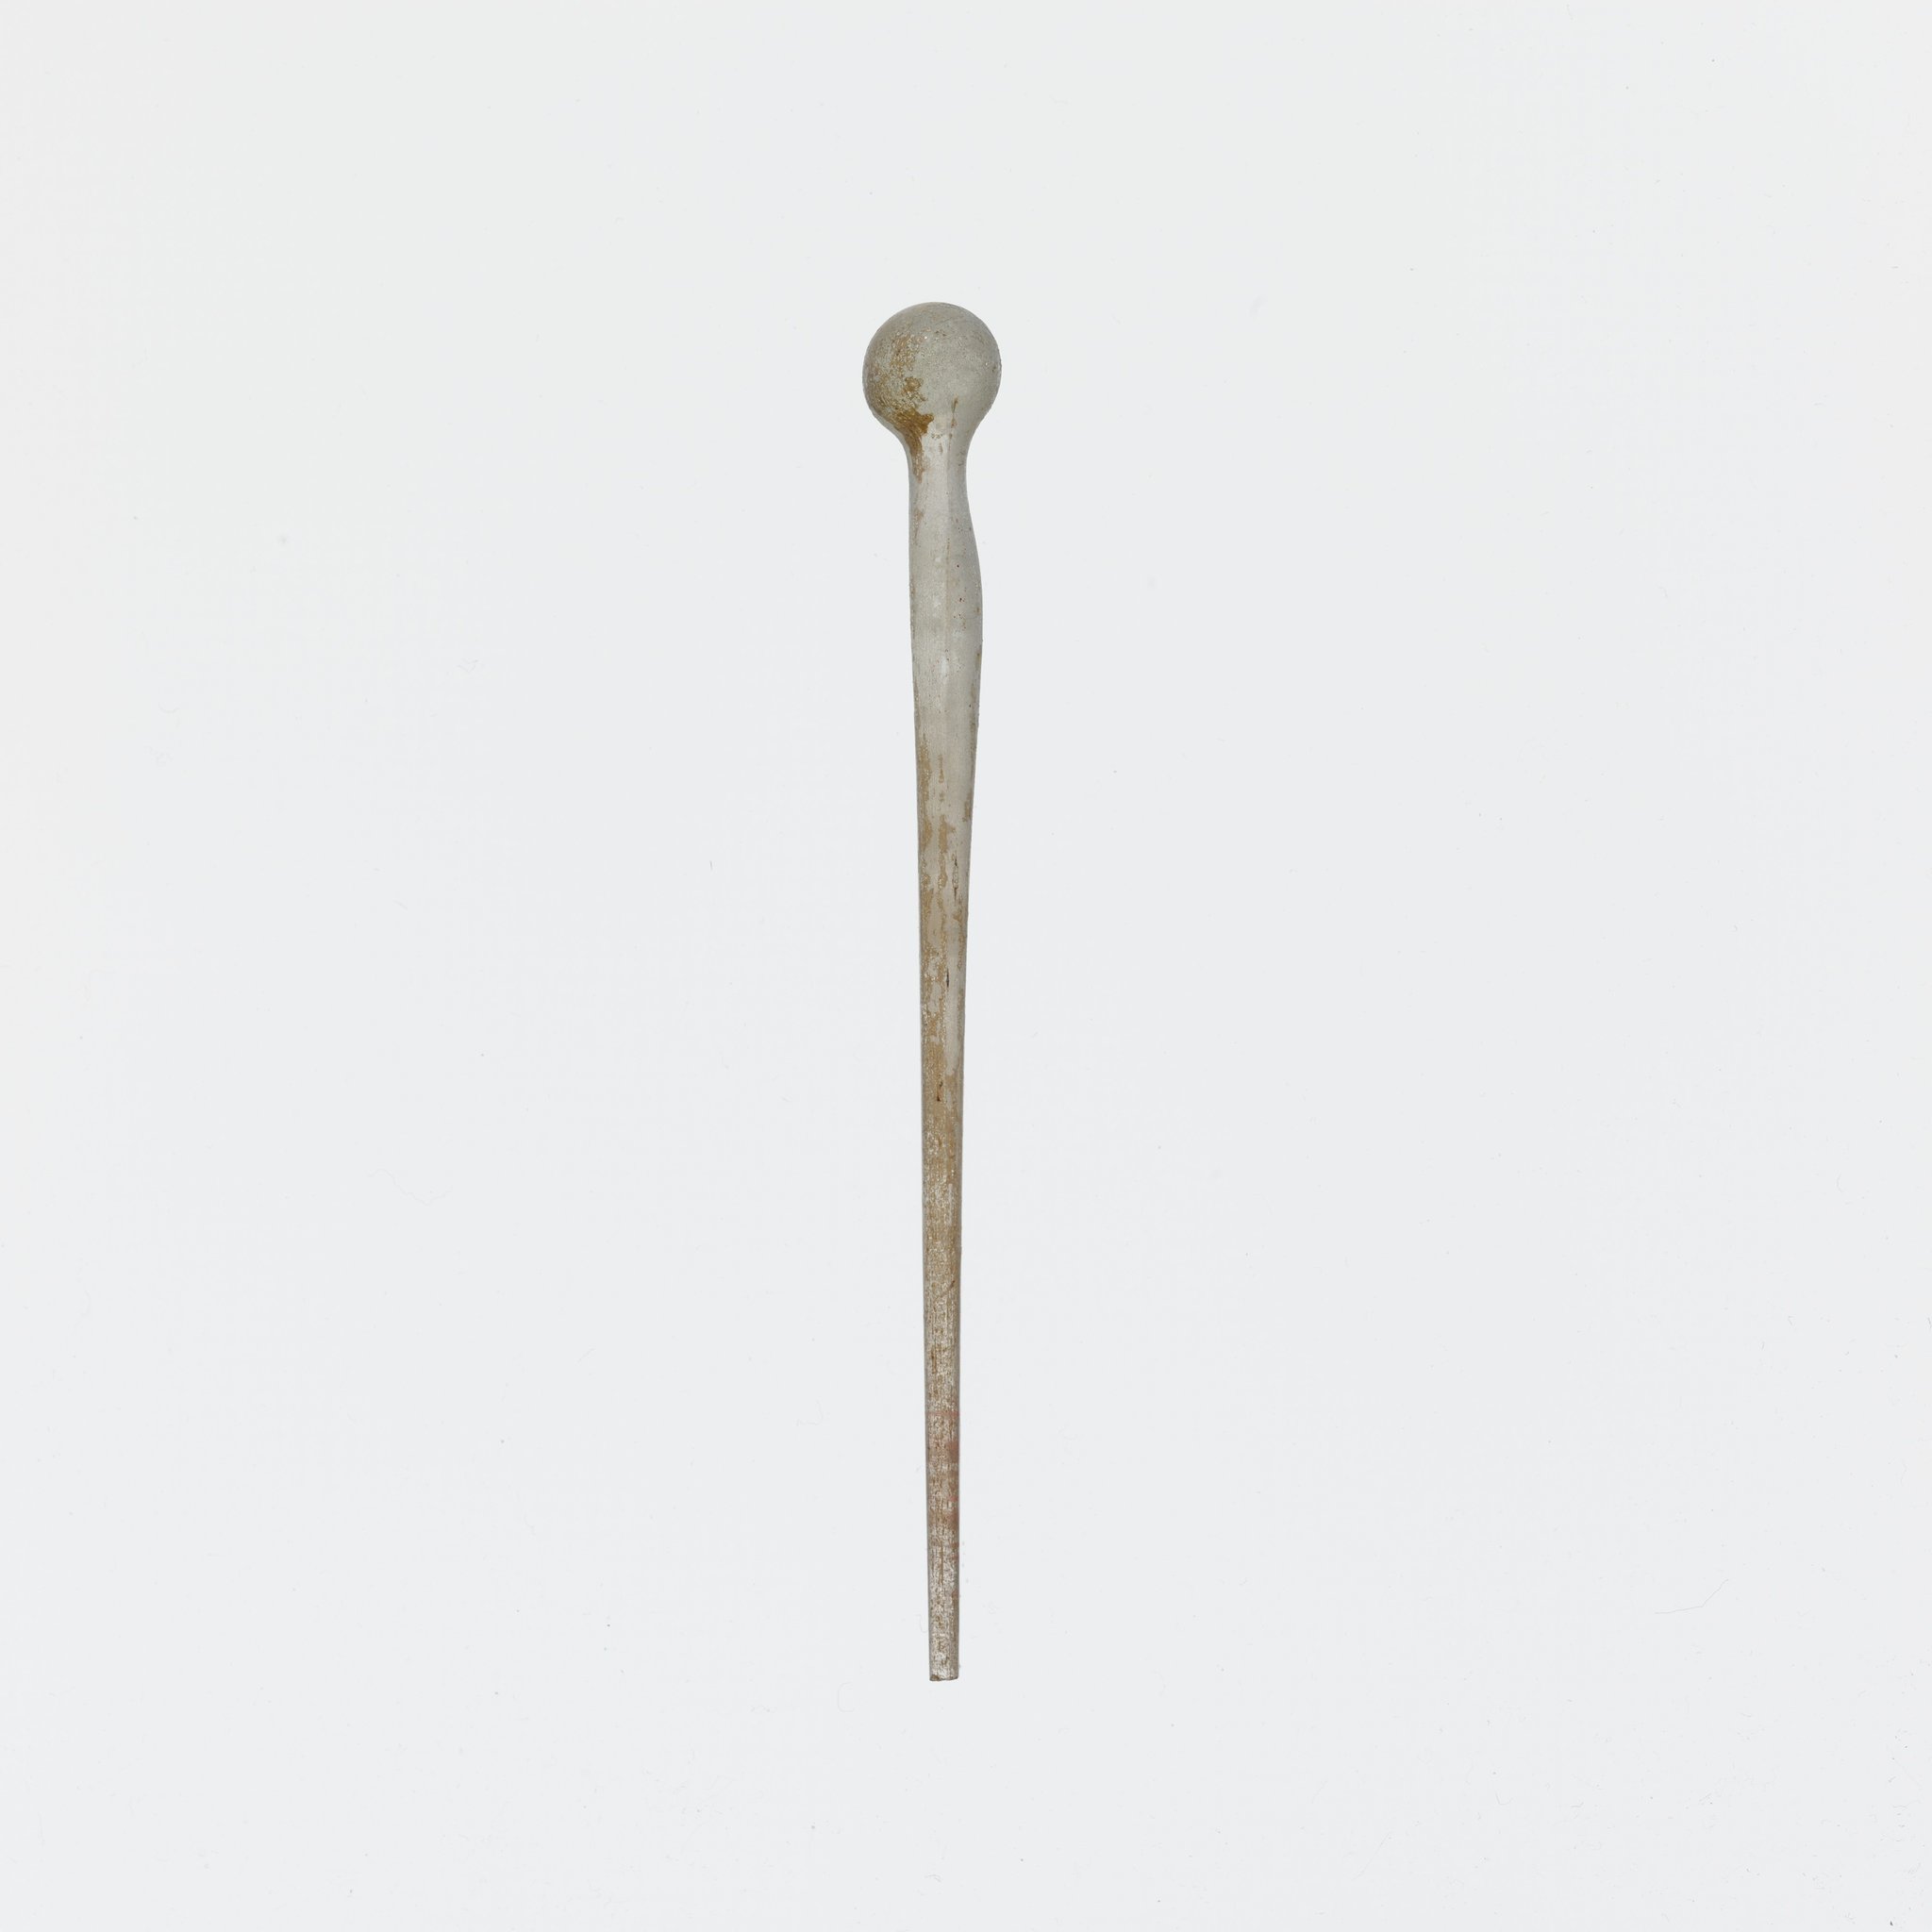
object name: pin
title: Glass pin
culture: roman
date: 1-400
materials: glass